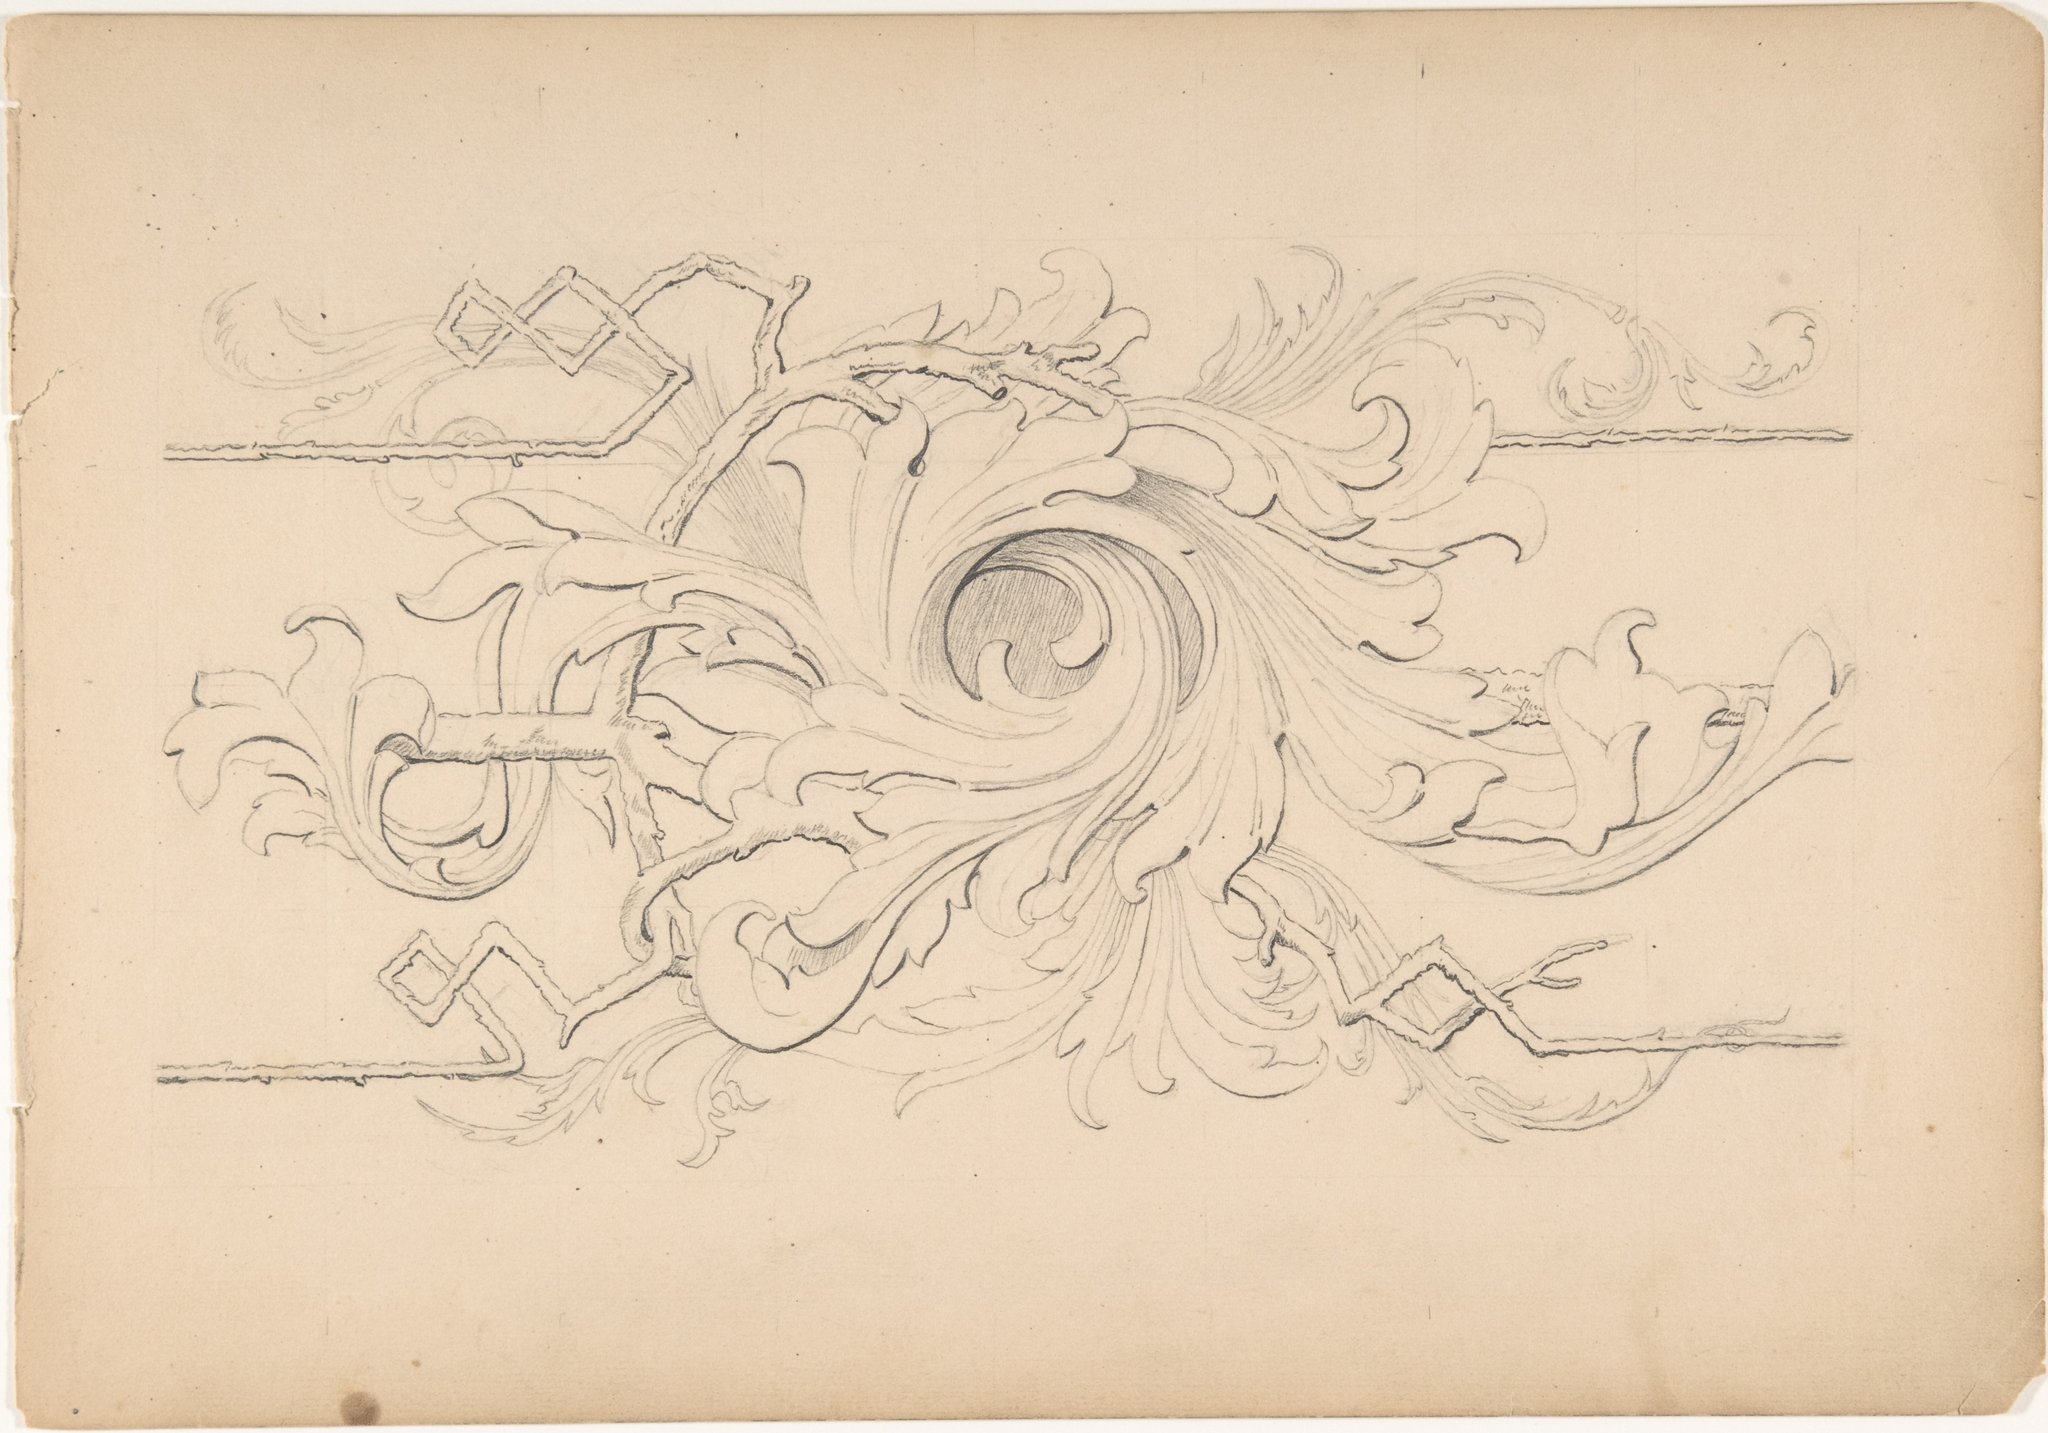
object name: drawing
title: Designs for borders and corners, acanthus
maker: robert william hume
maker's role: artist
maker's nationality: british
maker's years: 1816-1904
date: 1830-1904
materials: graphite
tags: acanthus